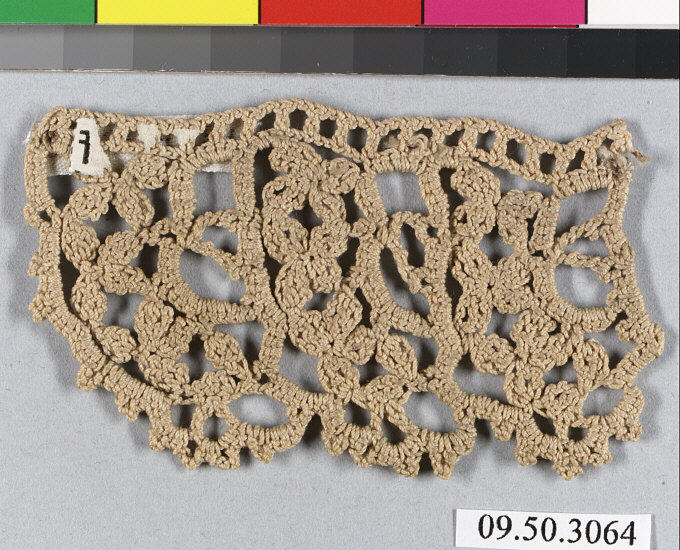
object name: sample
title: Crochet Work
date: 1801-1900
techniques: crochet